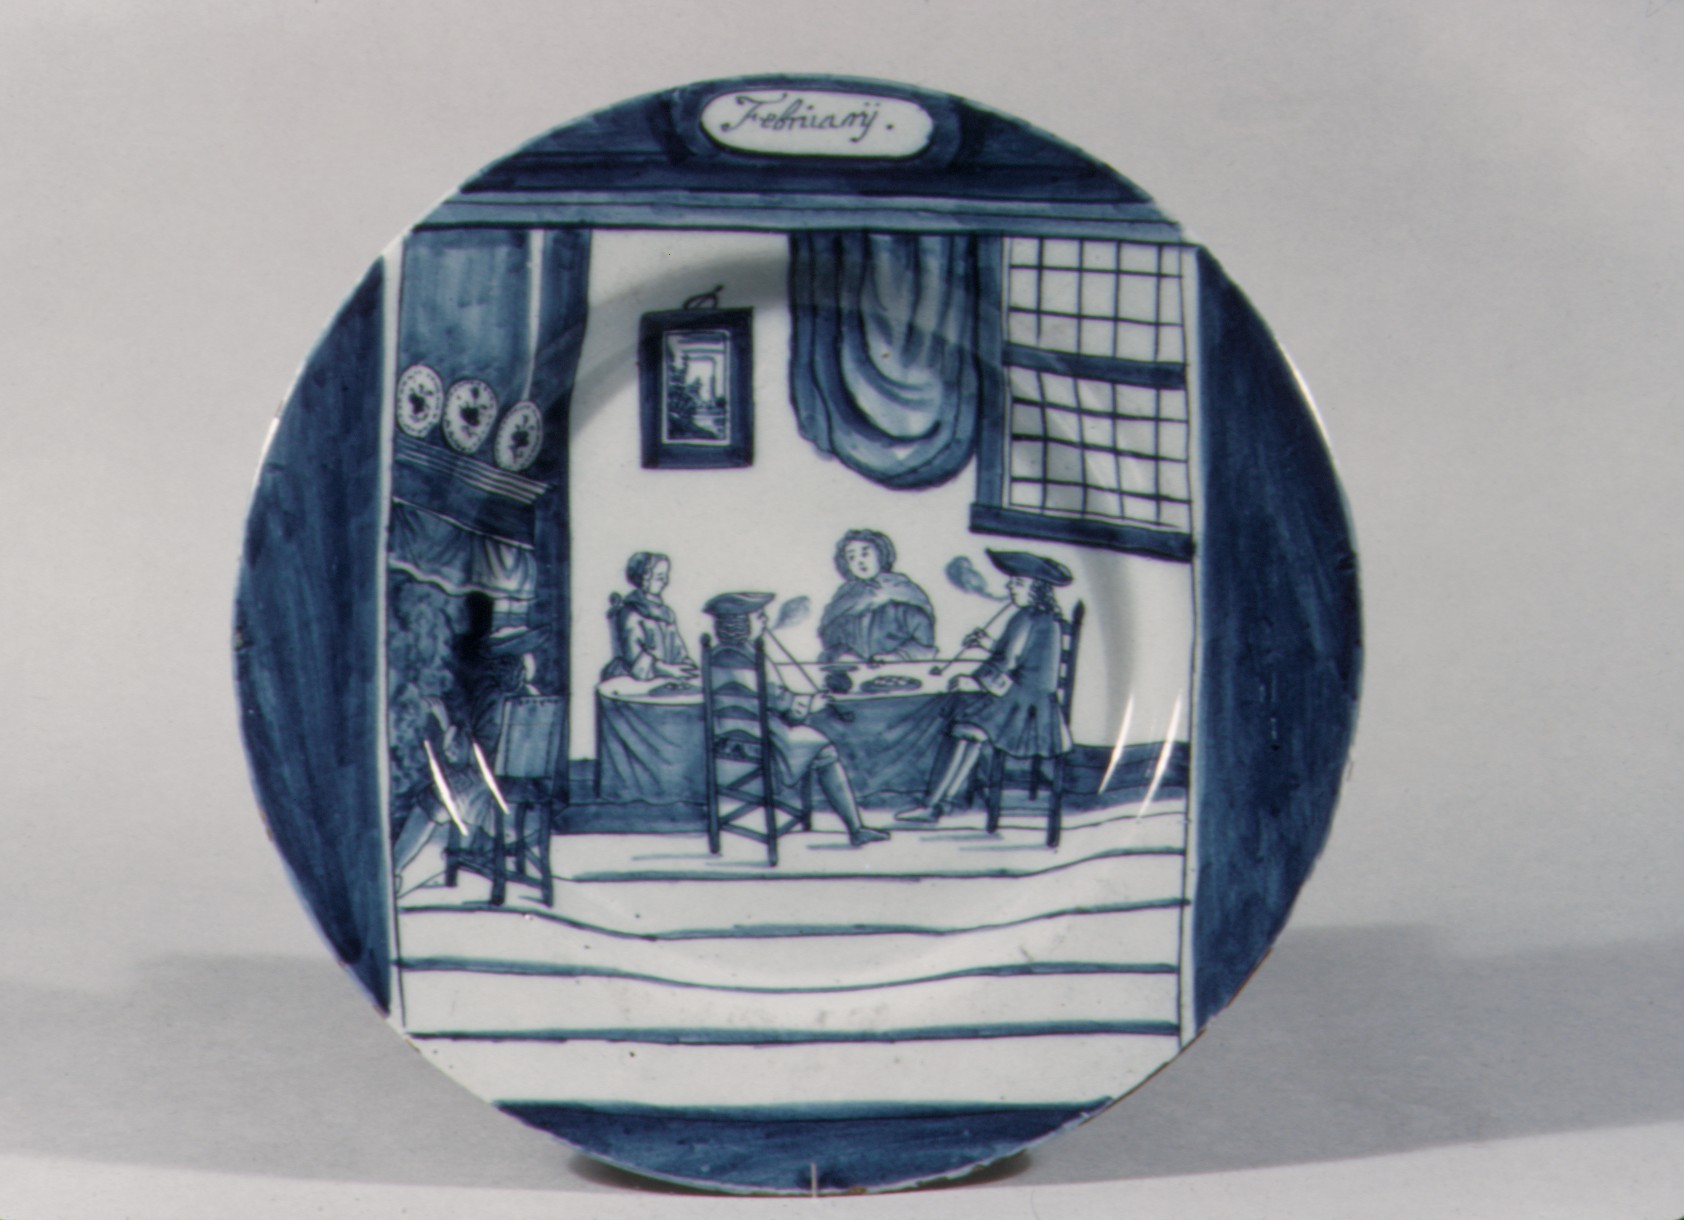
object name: plate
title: Plate (part of a set)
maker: de porceleyne bijl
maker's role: maker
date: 1764-1788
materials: earthenware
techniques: glazing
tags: men,women,smoking